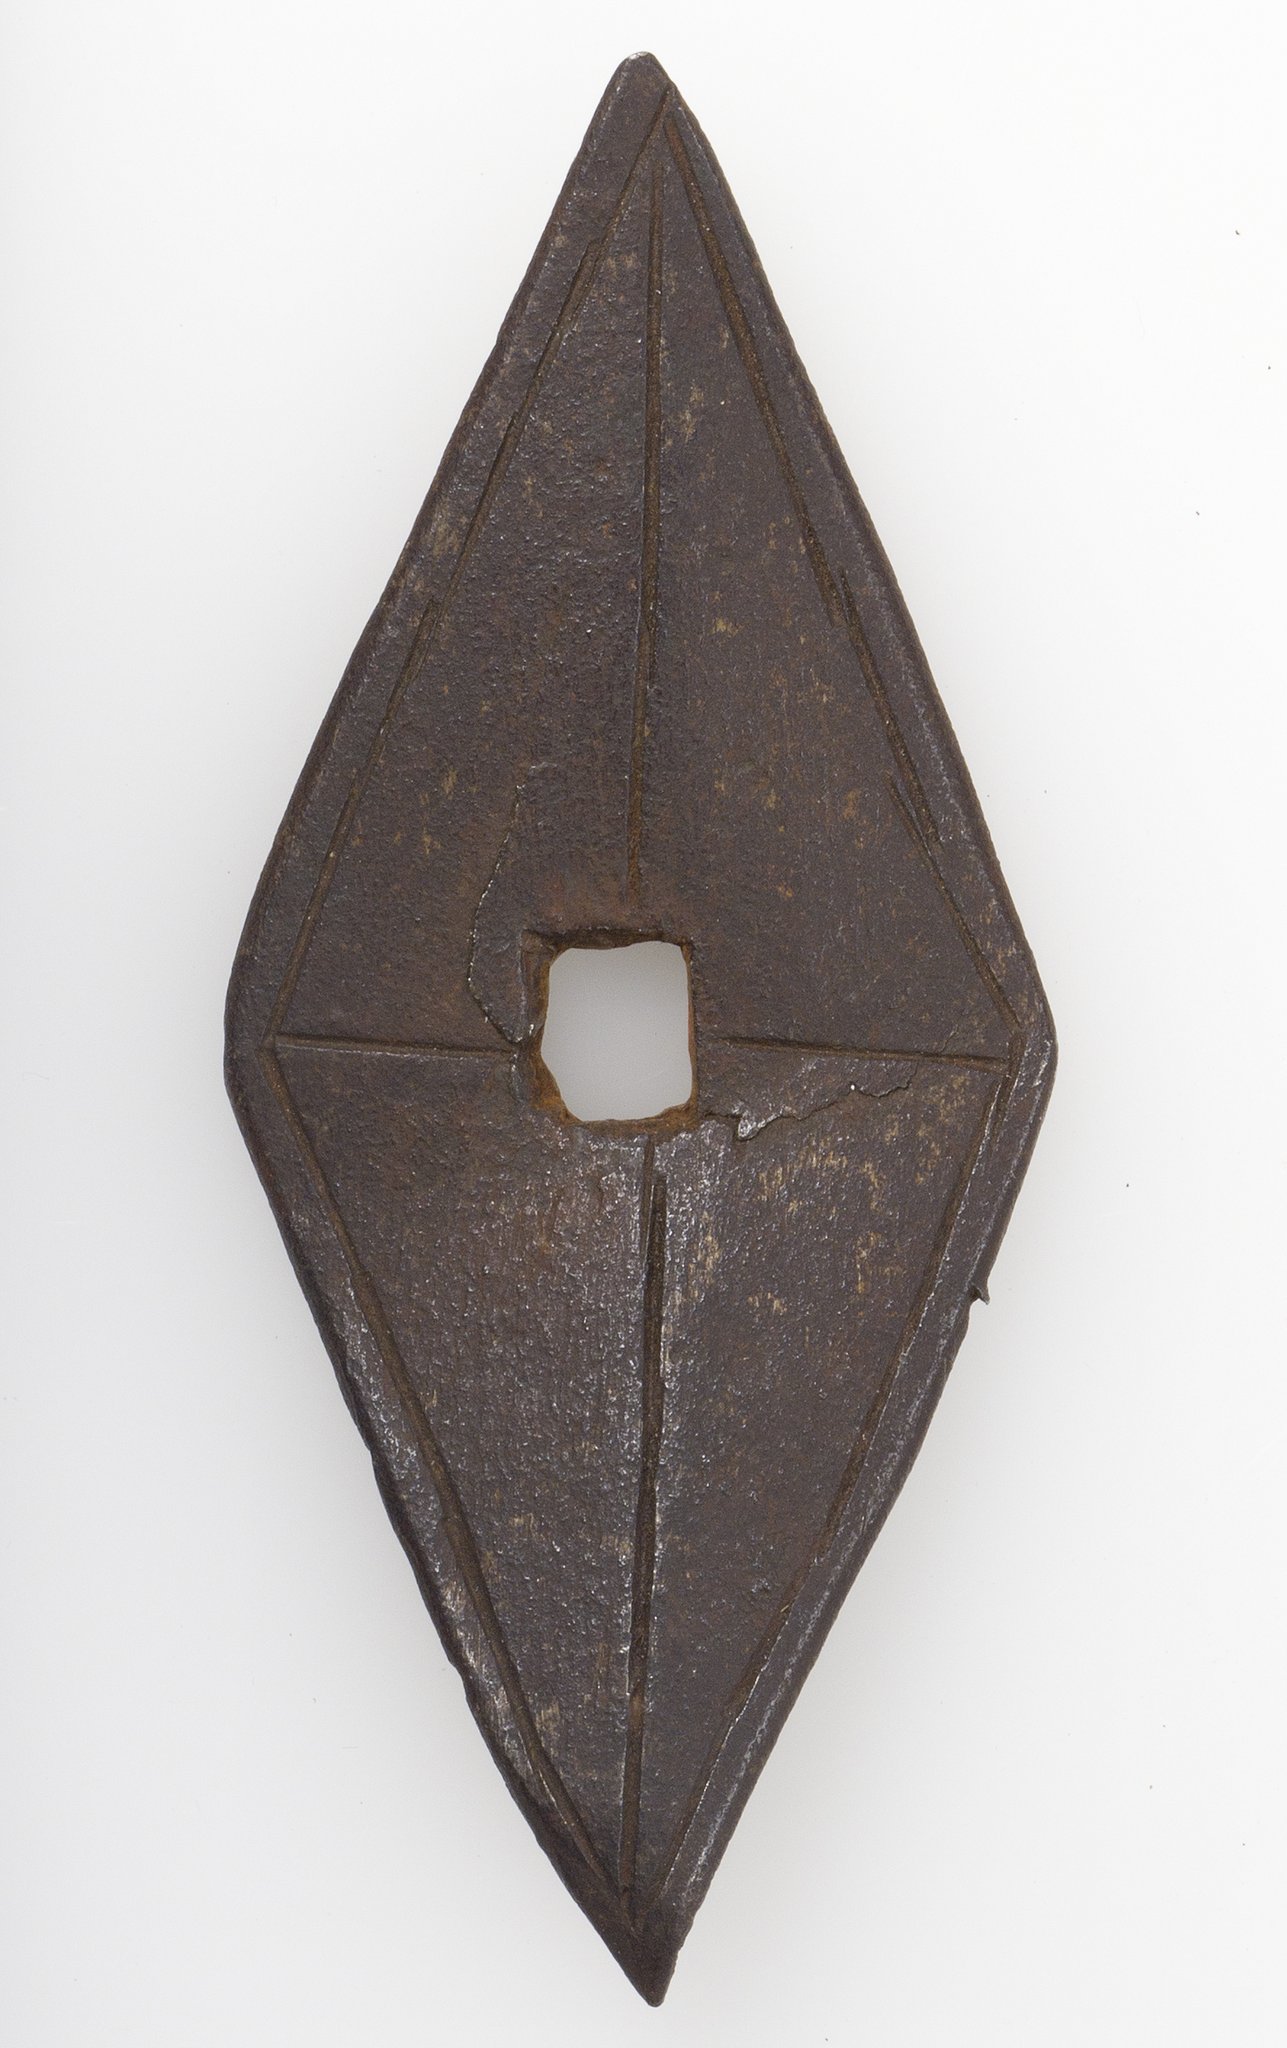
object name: plate and nail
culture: european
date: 1401-1600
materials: iron